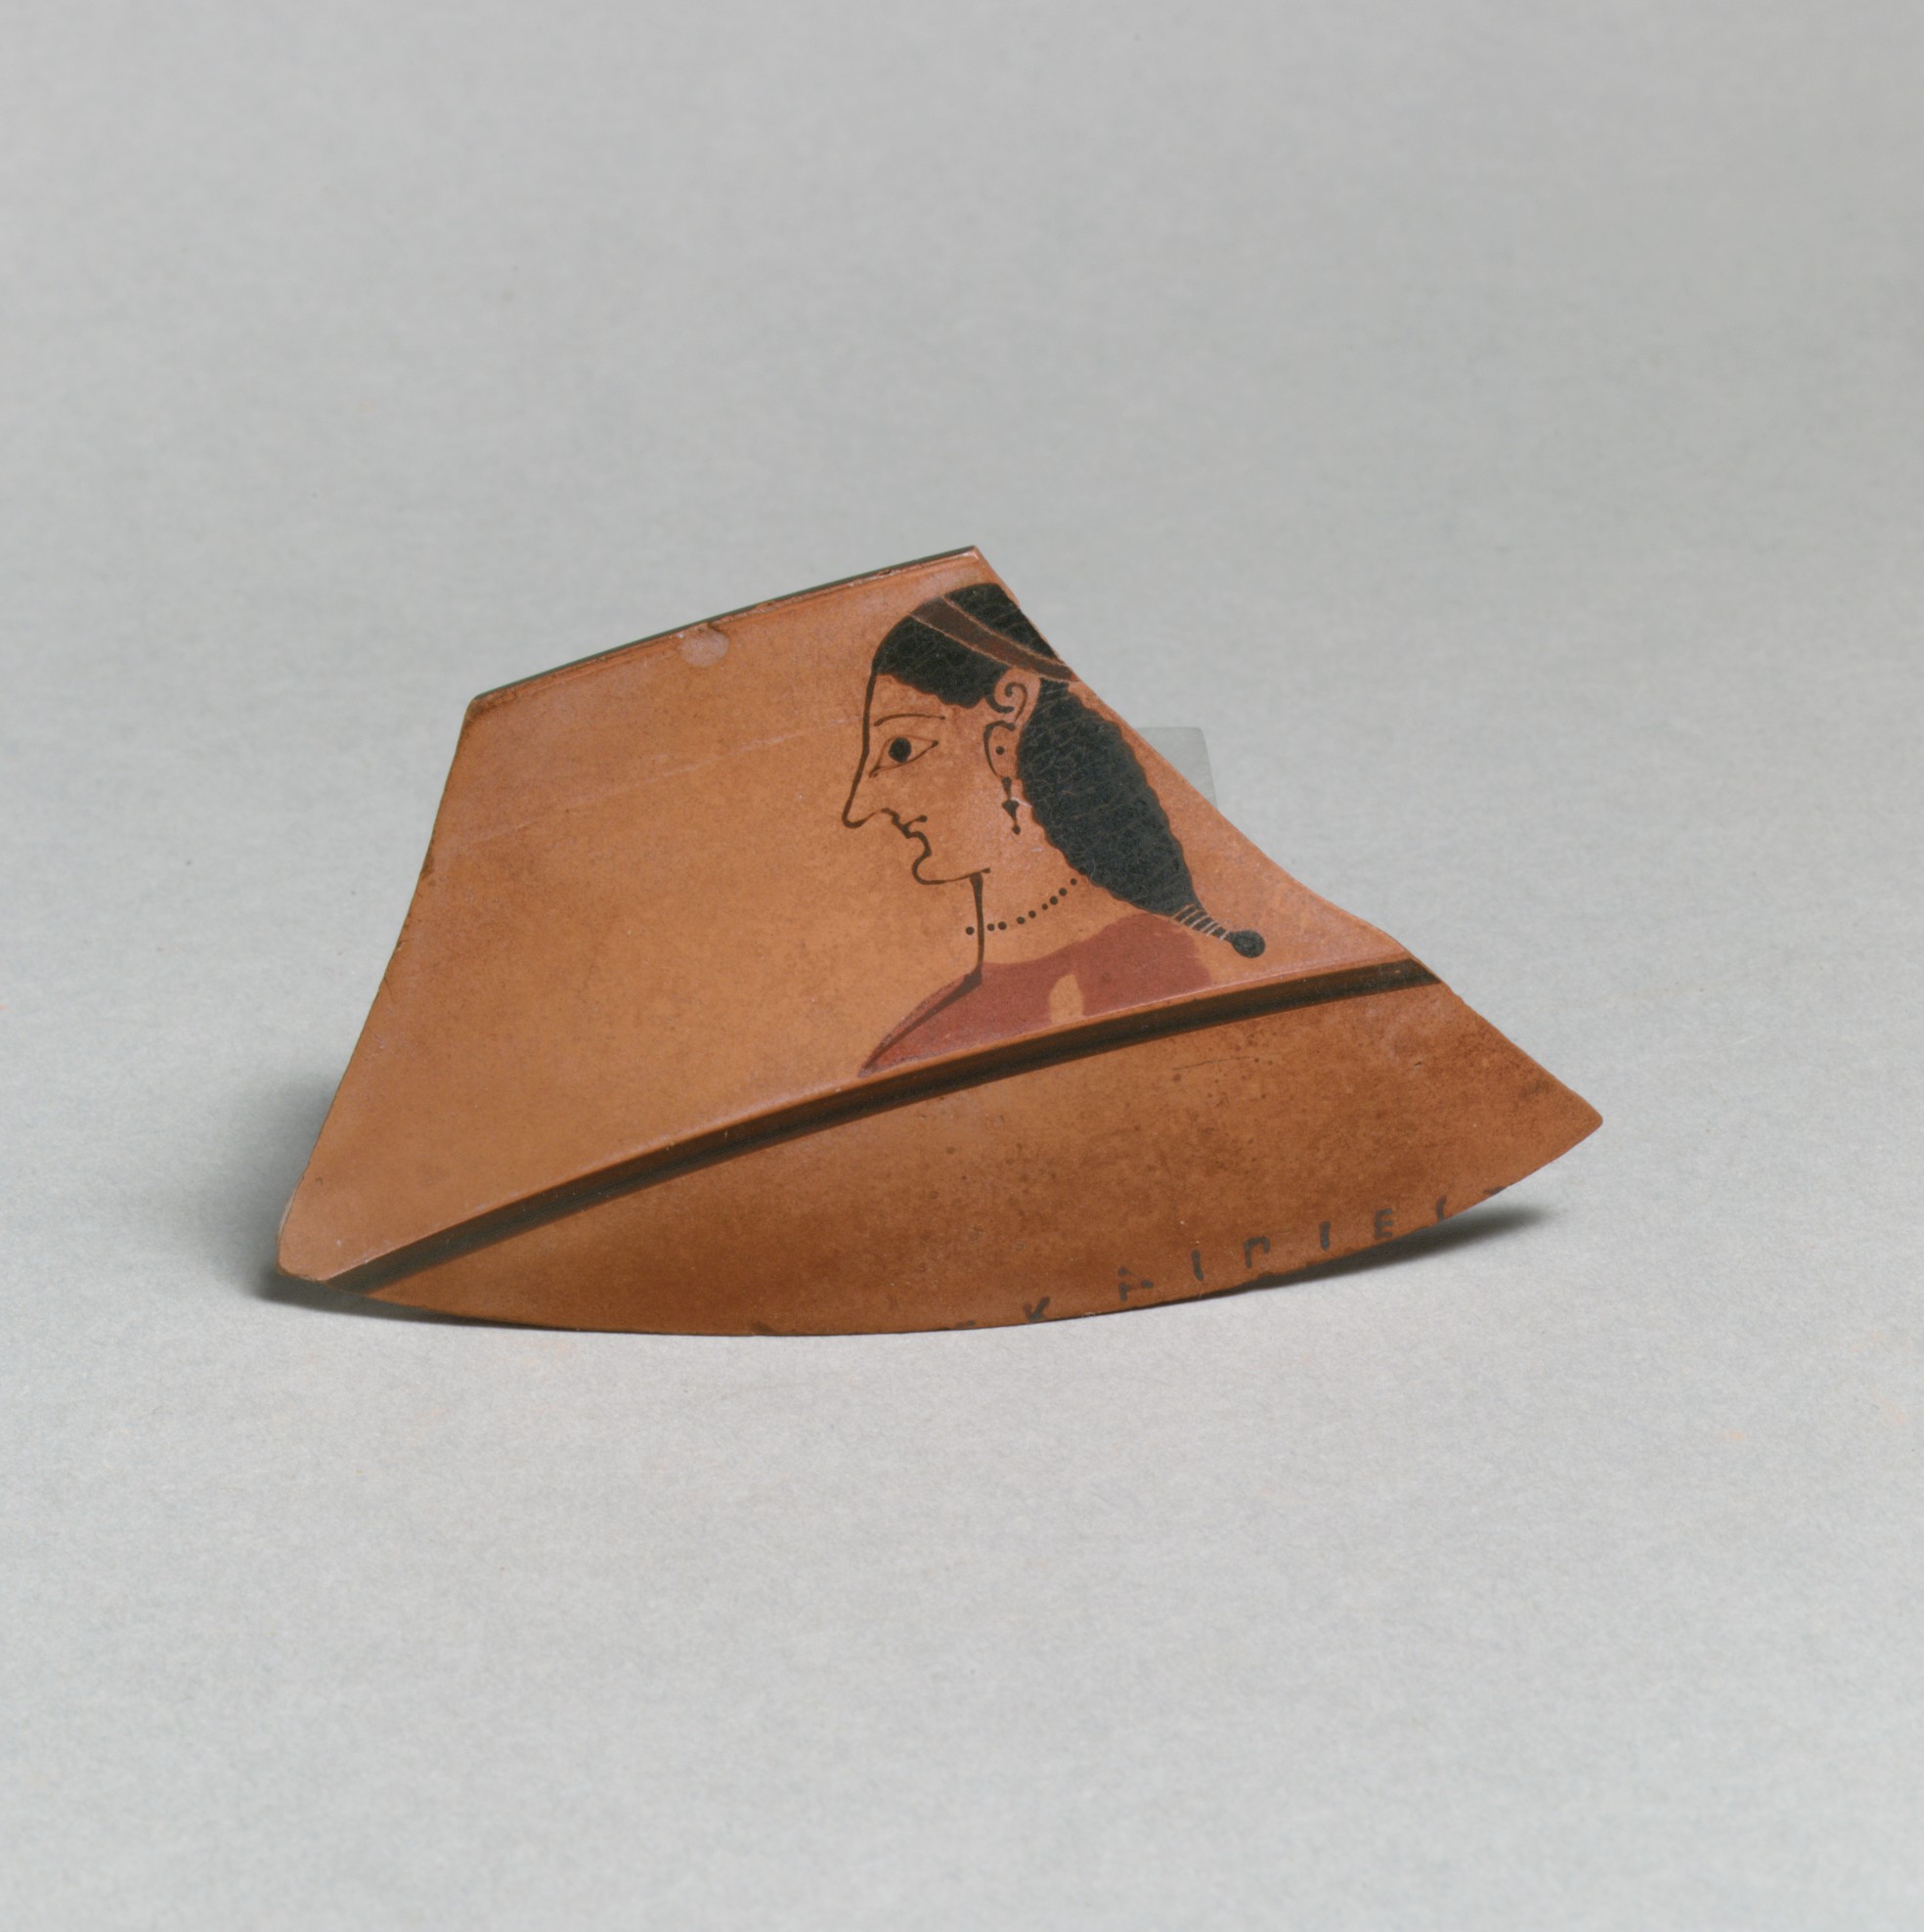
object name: kylix, lip cup fragment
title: Fragment of a terracotta kylix: lip-cup (drinking cup)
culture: greek, attic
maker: sakonides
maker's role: artist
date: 550-526 BCE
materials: terracotta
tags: women